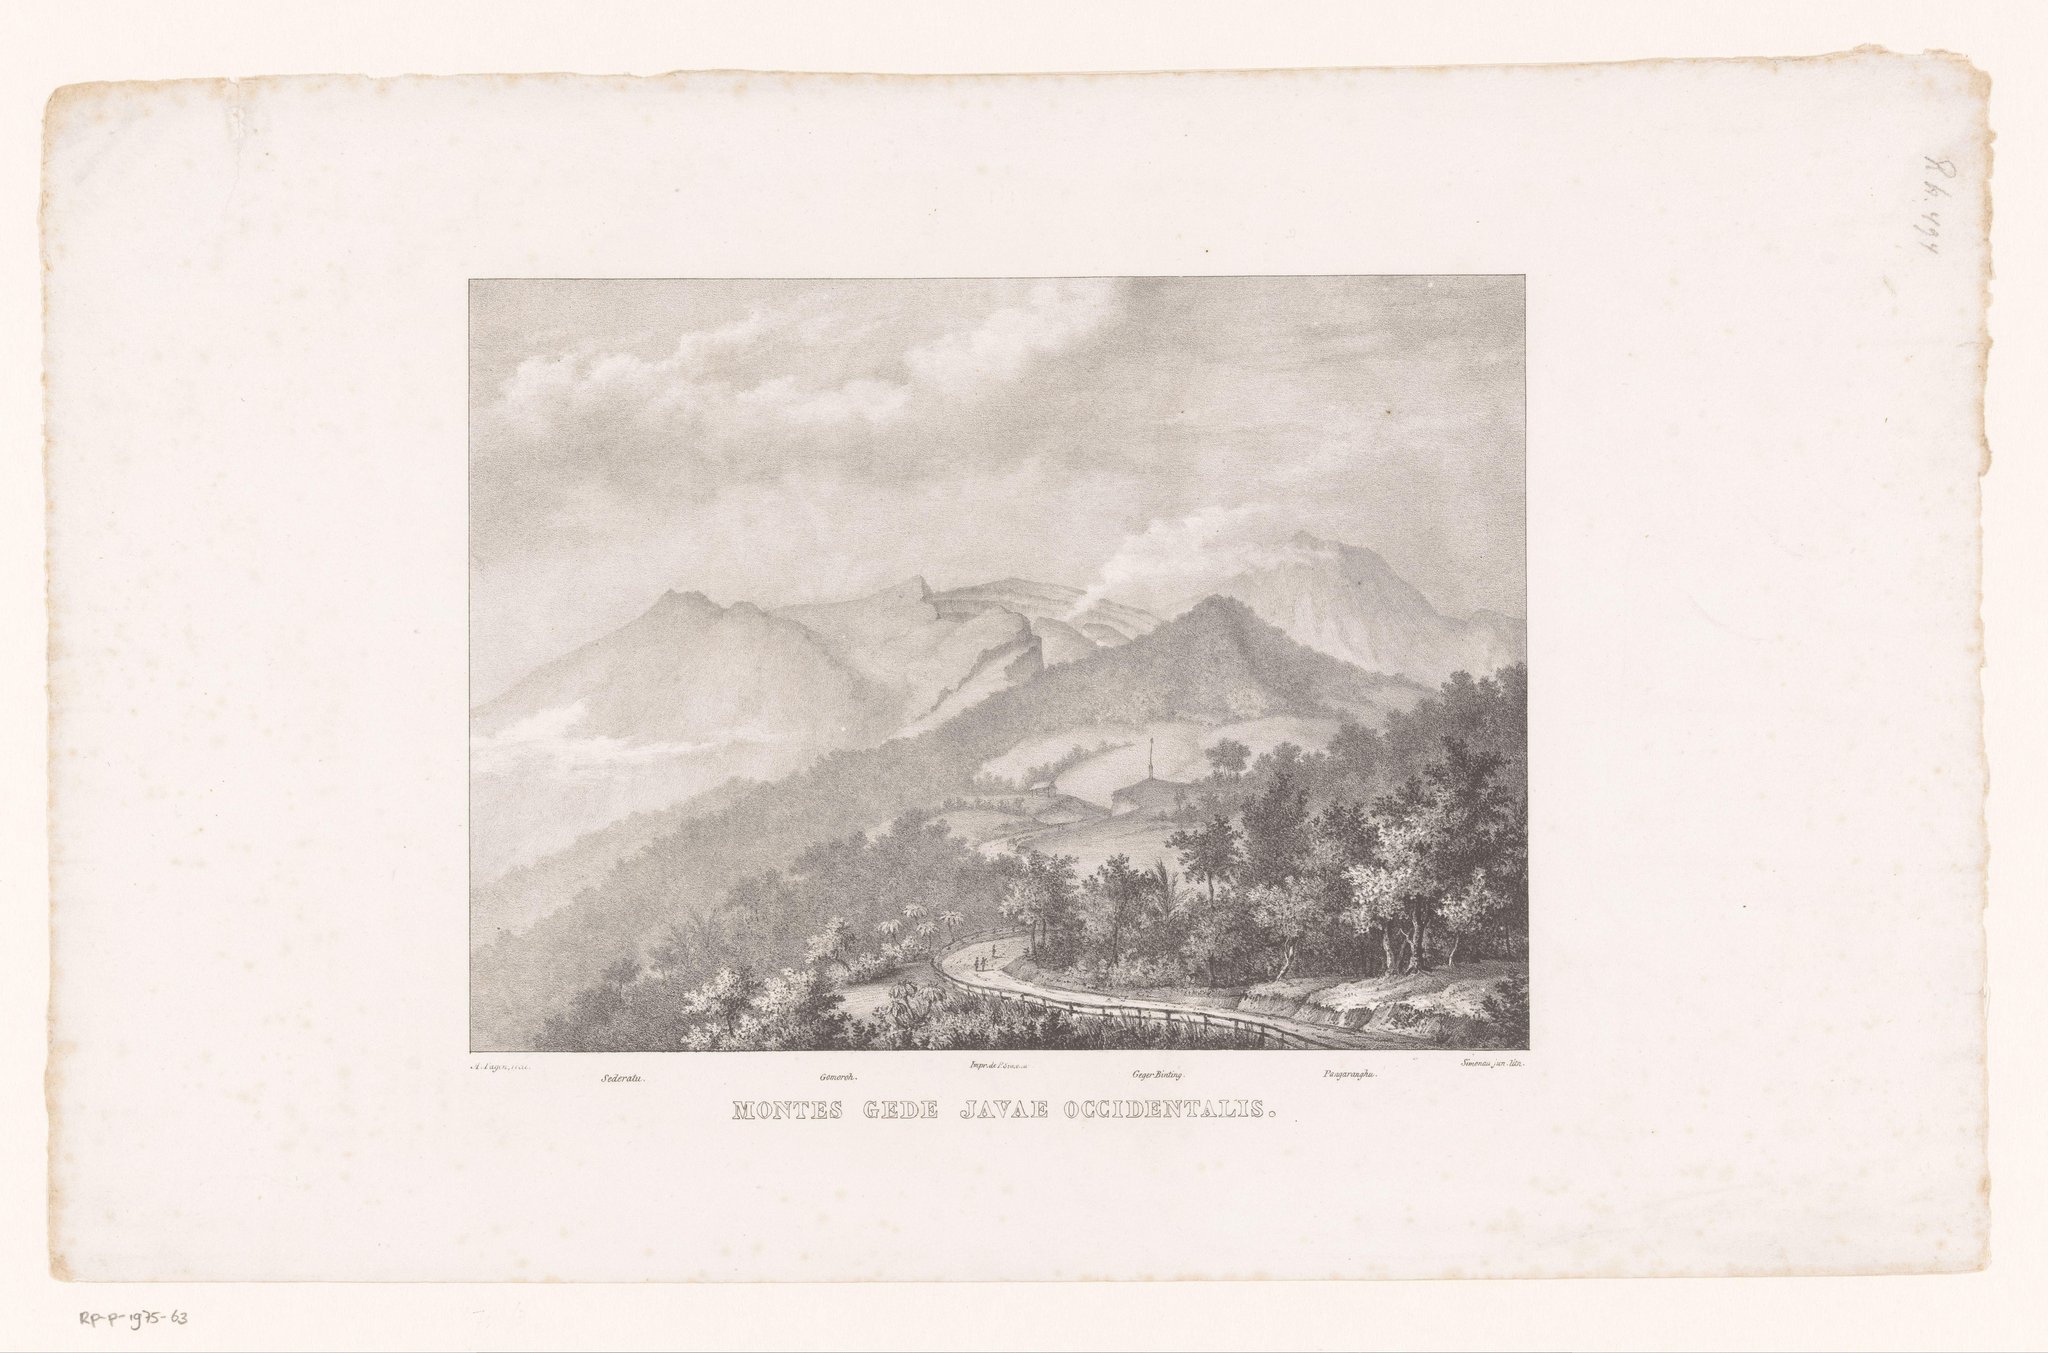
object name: print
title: Gede, vulkaan op West-Java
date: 1821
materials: paper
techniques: lithograph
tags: volcano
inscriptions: collector's mark: Lugt 2228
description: Geger Binting en Pangaranghu zijn namen van wetenschappers, mogelijk botanici.